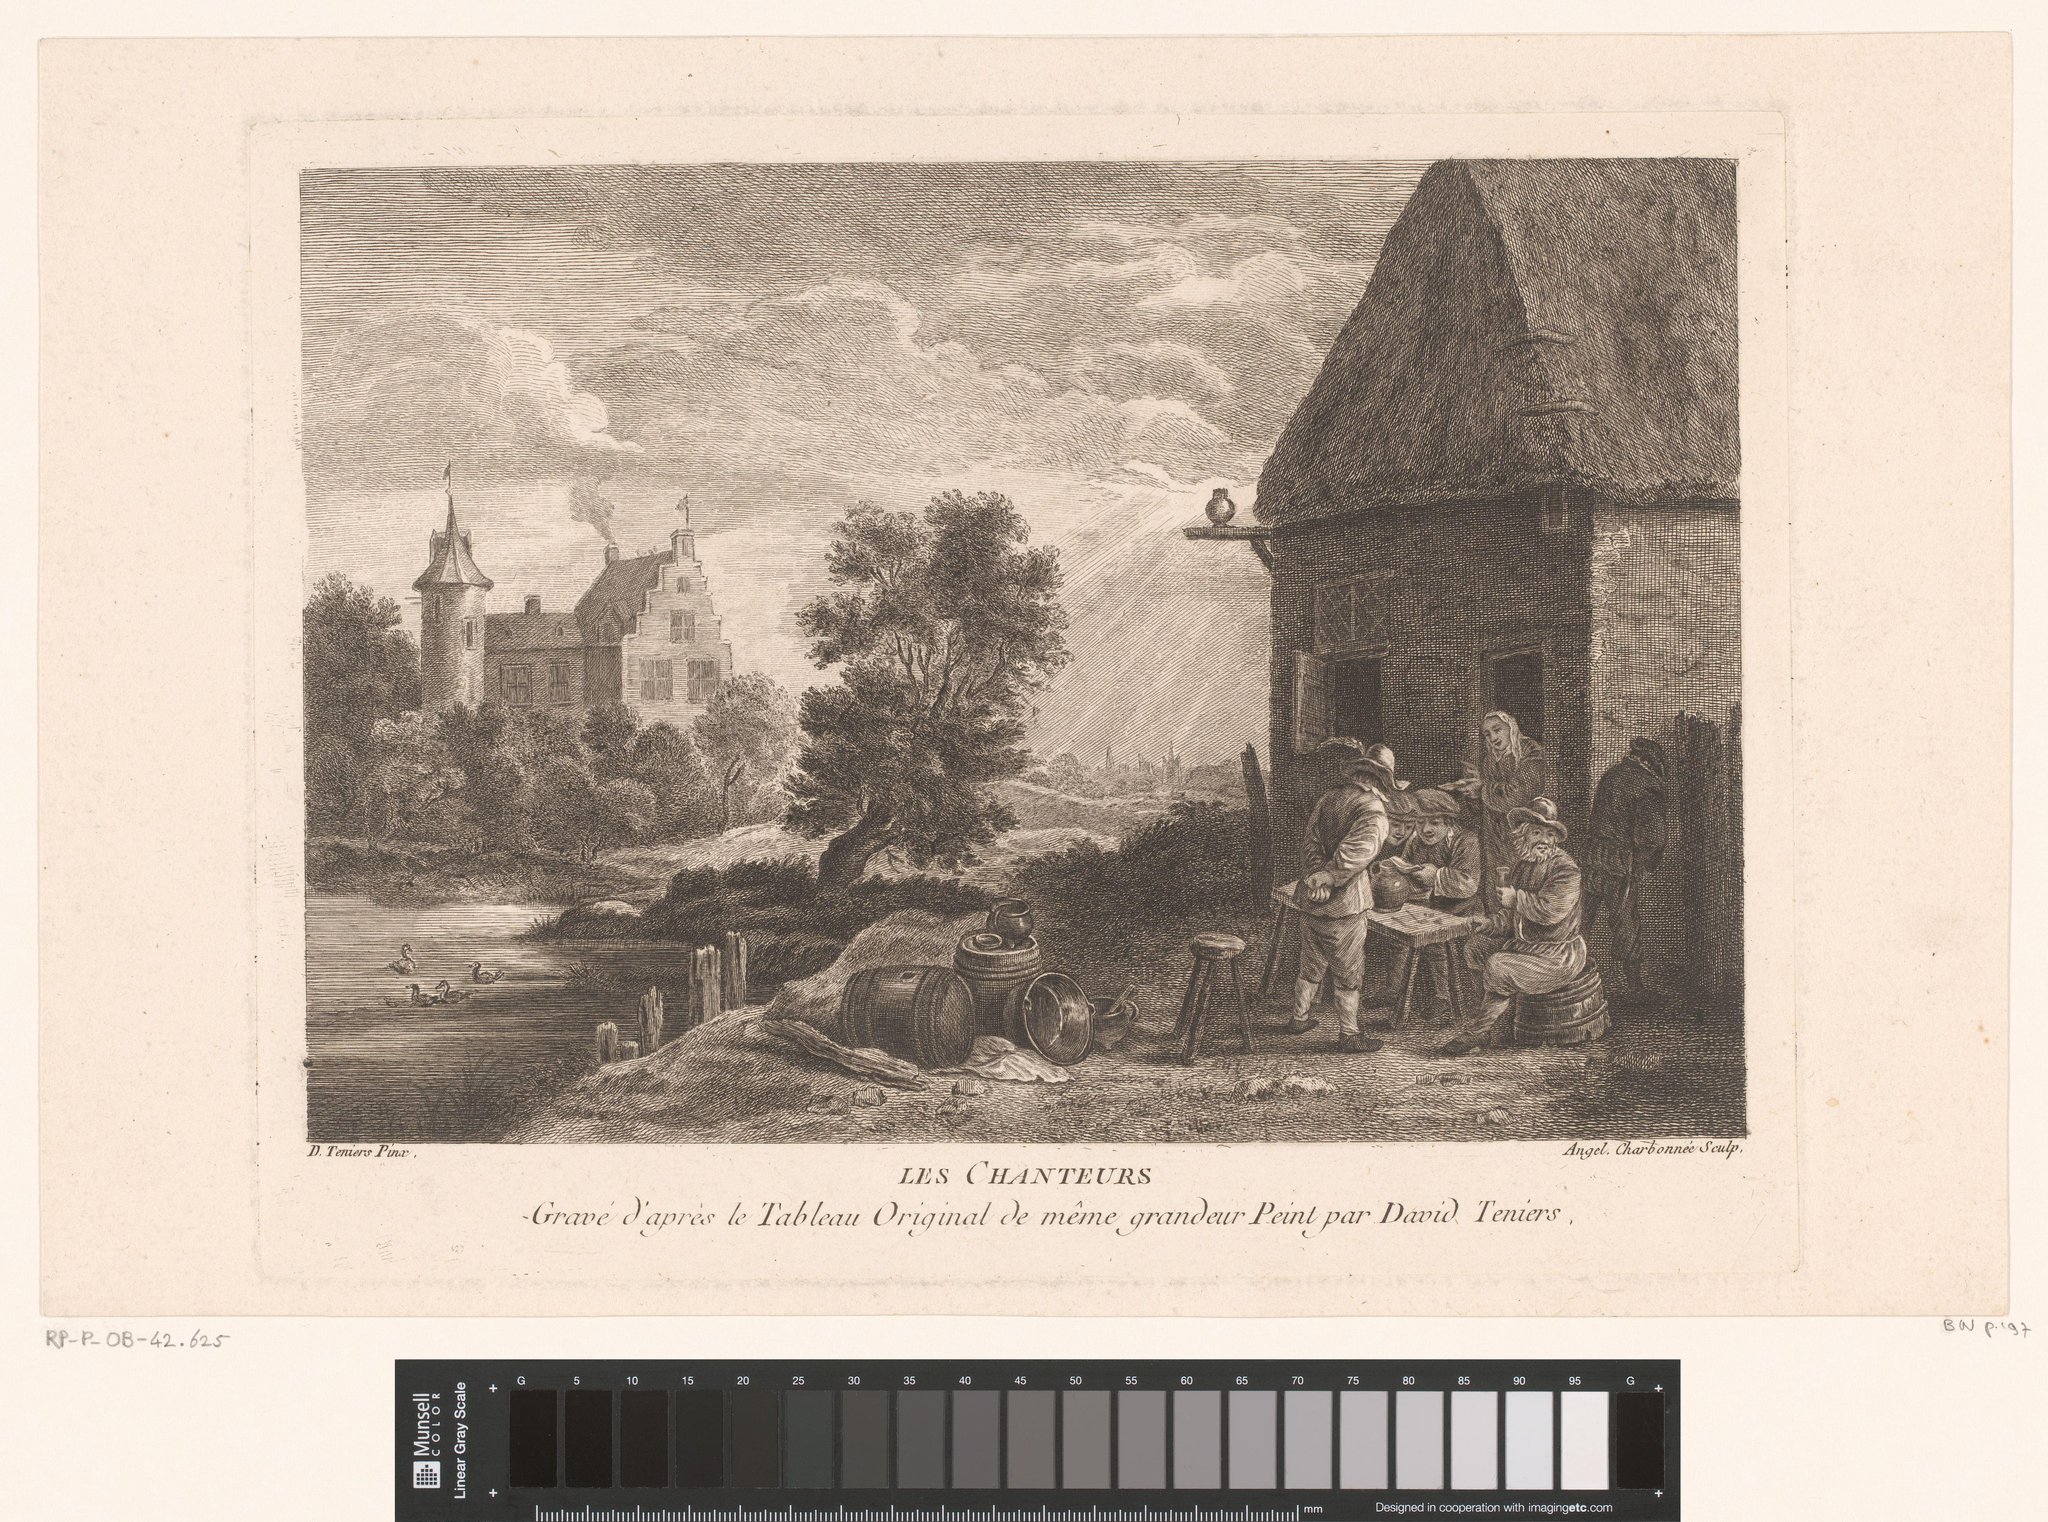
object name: print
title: Les Chanteurs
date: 1700-1799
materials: paper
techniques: etching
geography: france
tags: hotel, hostelry, inn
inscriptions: collector's mark: Lugt 2228